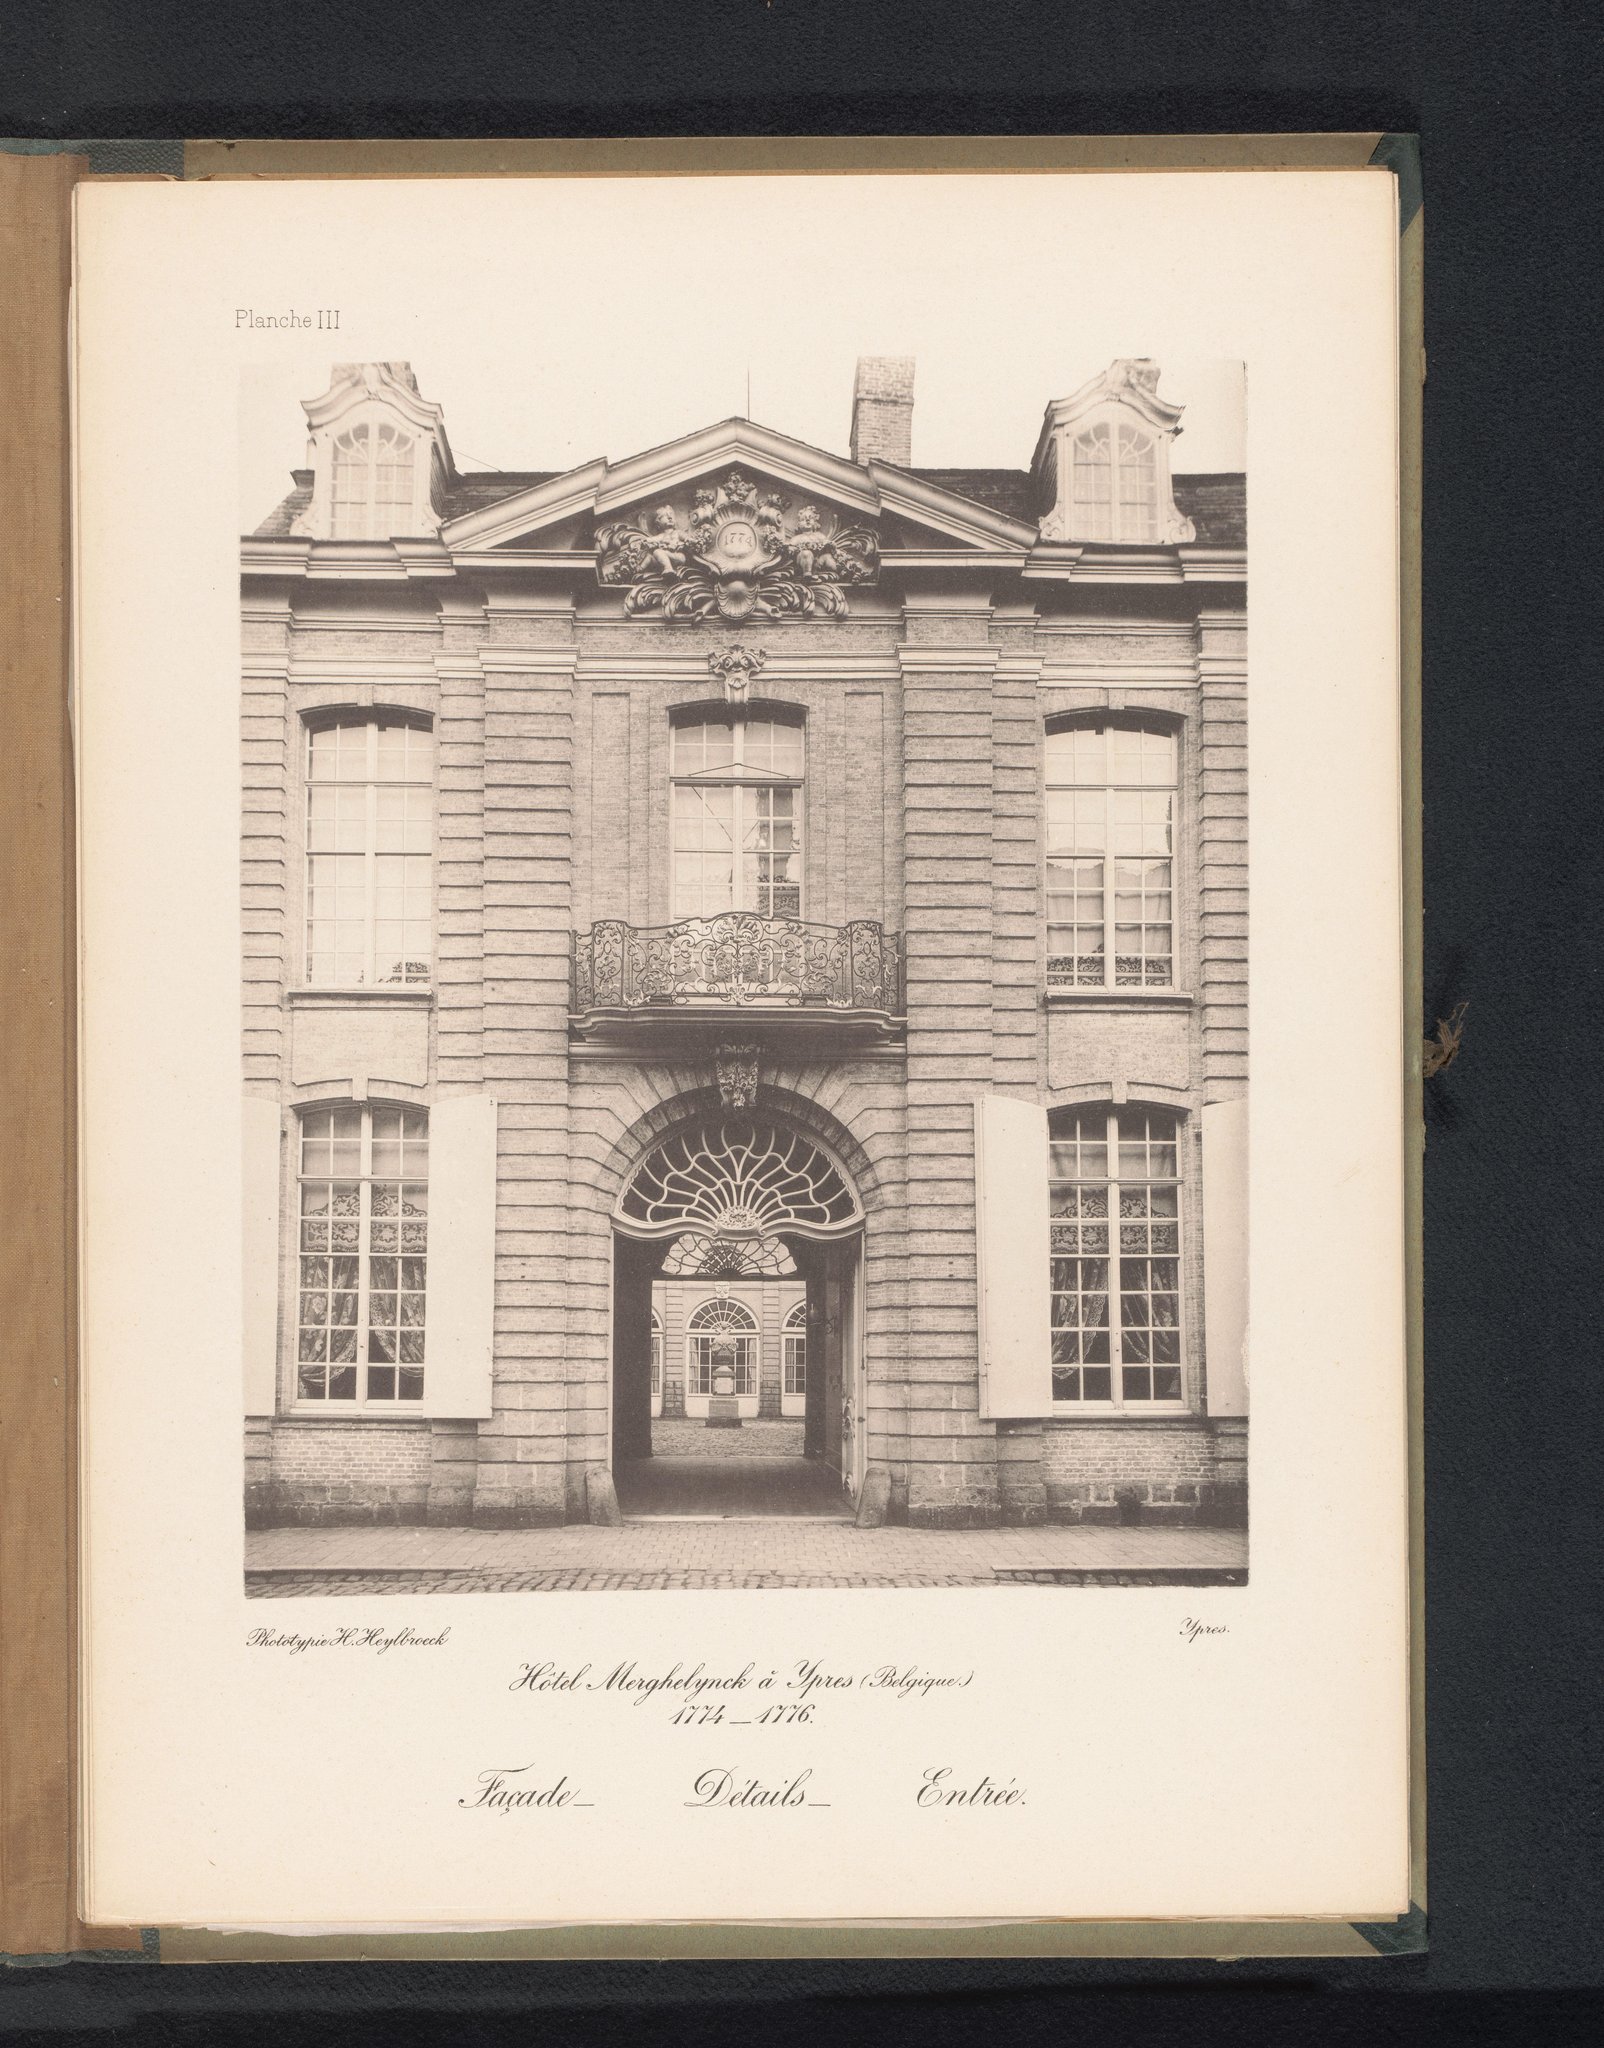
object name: photomechanical print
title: Façade - Détails - Entrée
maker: hector heylbroeck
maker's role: fotograaf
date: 1889-1894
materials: paper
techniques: photograph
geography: ieper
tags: gate, entrance, hotel, hostelry, inn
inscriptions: inscription: ‘Ypres.’, number: ‘Planche III’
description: Deze prent maakt deel uit van een omslag met 31 prenten en een katern met teksten.